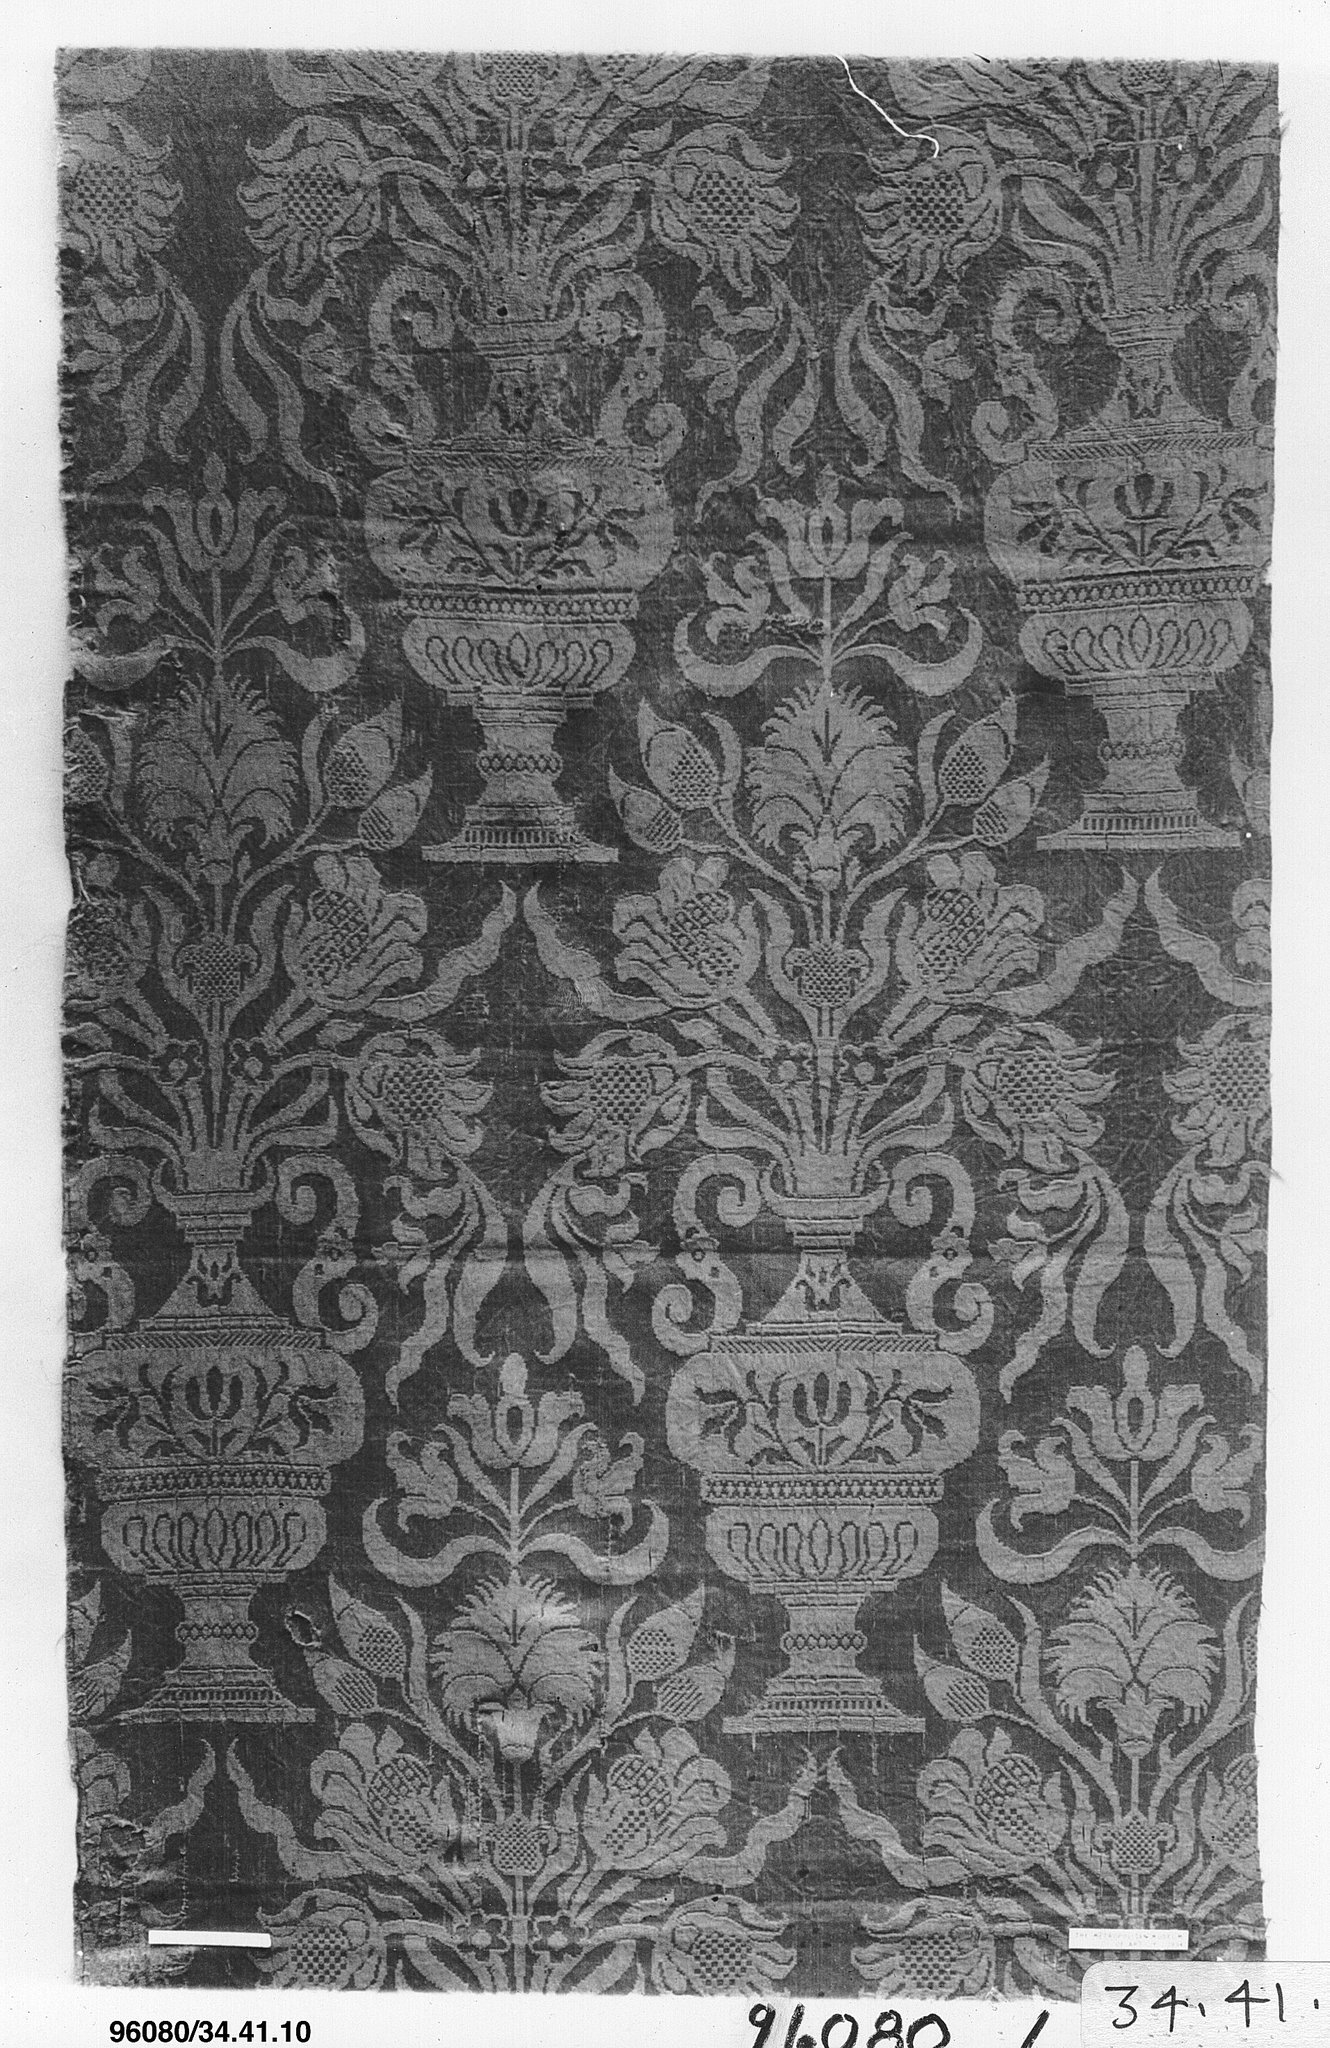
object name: piece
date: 1601-1700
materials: silk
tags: flowers,leaves